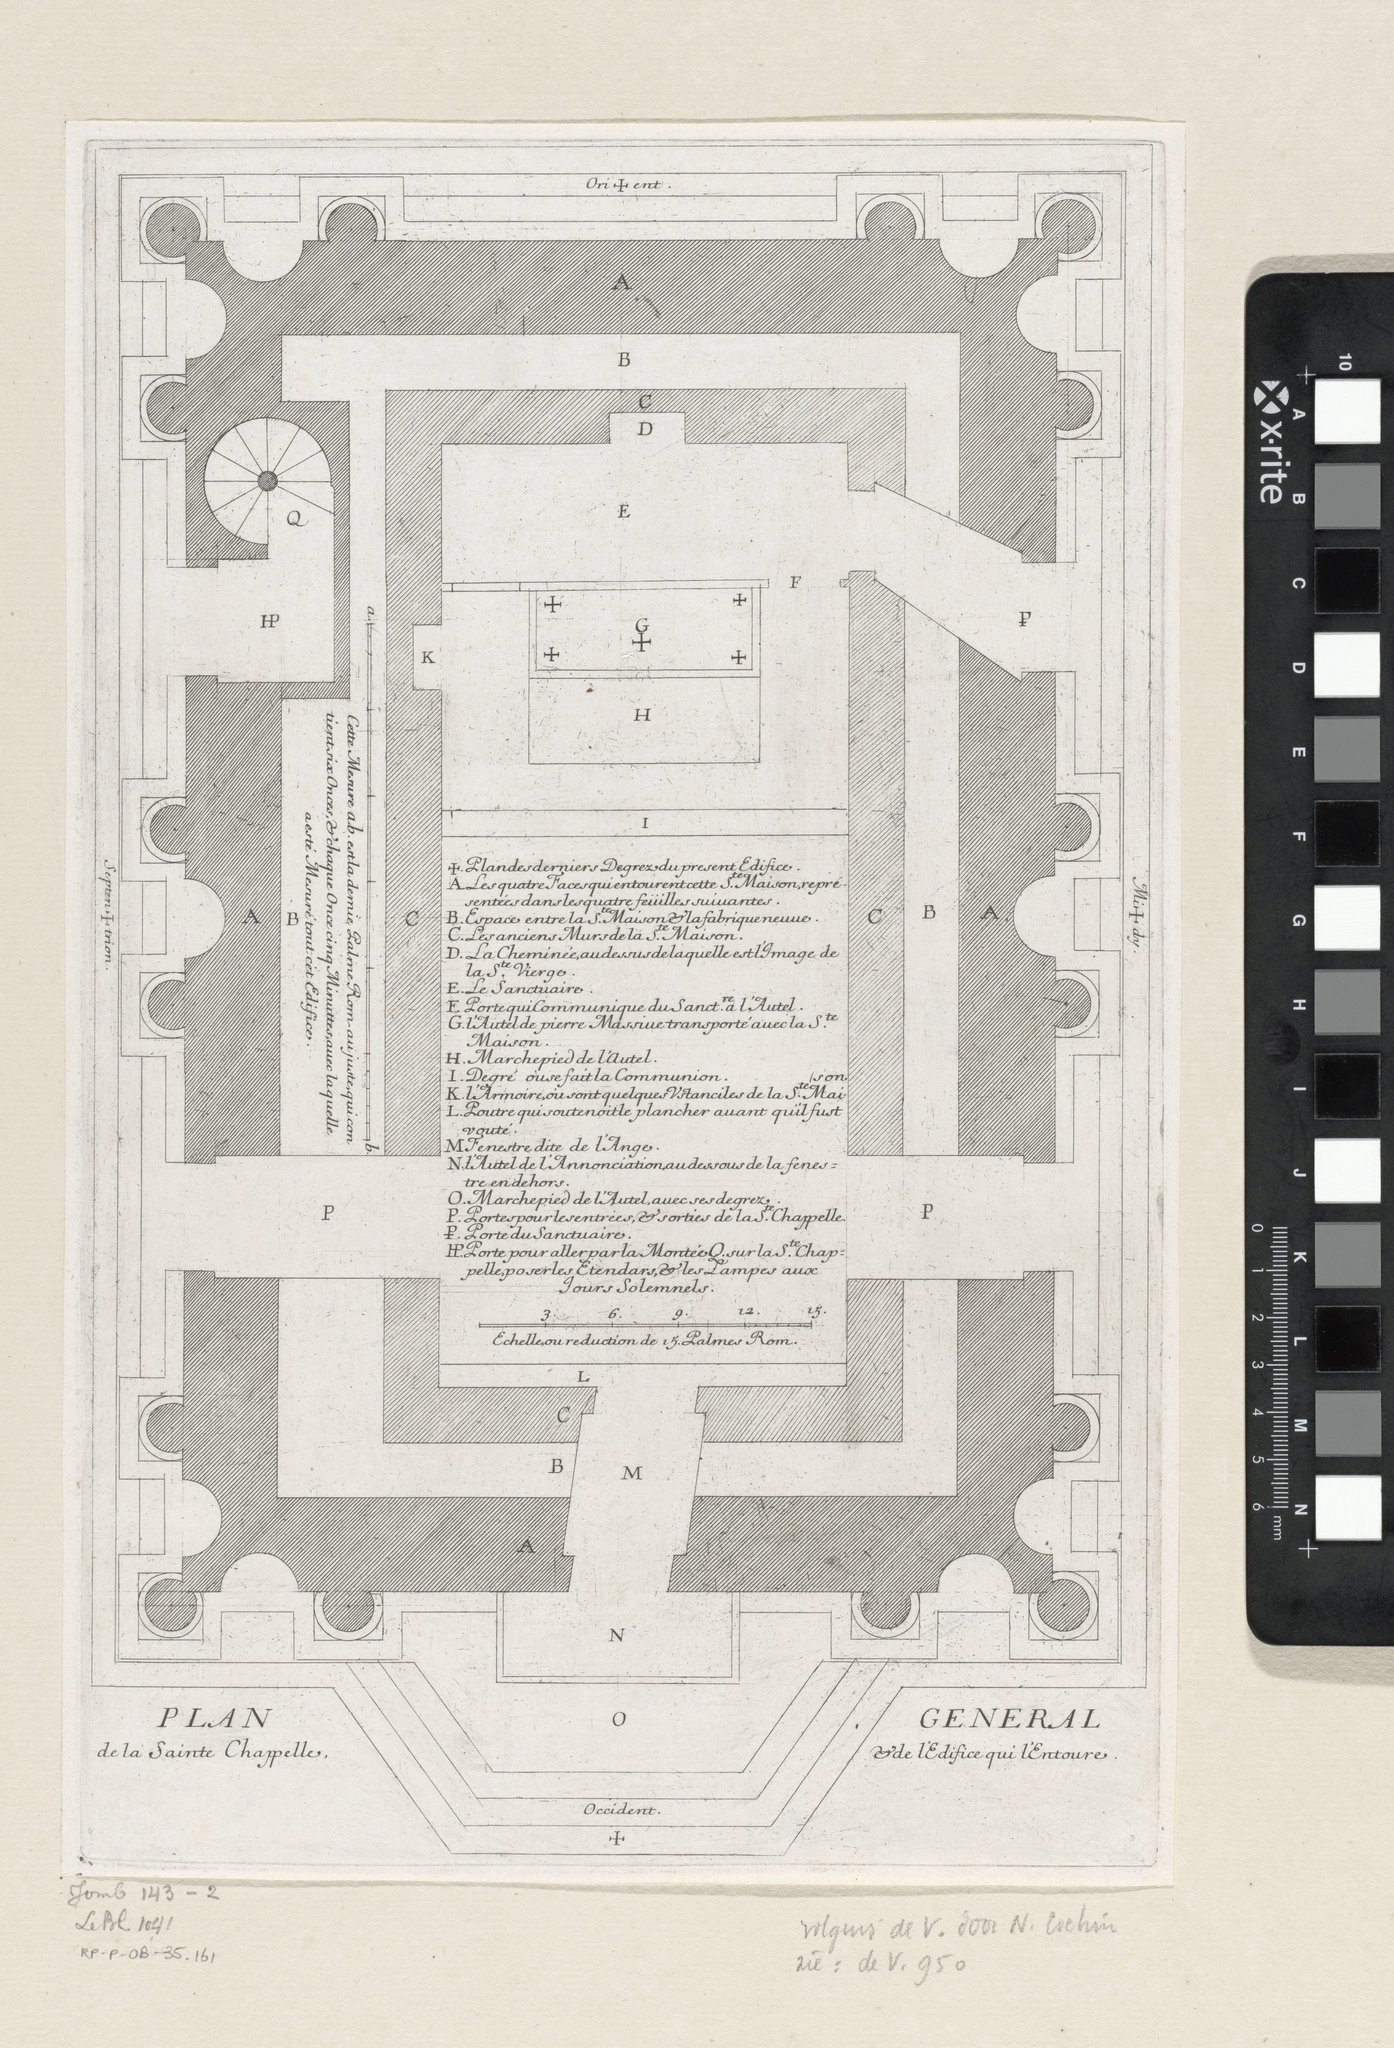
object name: print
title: Plan general de la Sainte Chapelle & l'edifice qui l'entoure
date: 1649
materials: paper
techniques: etching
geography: paris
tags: plan ~ architecture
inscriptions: collector's mark: Lugt 240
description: Prent mogelijk gebruikt als illustratie in: Le véritable plan et pourtrait de la maison de la Ste. Vierge Maria de Lorette. Parijs: Pierre Mariette 1649.